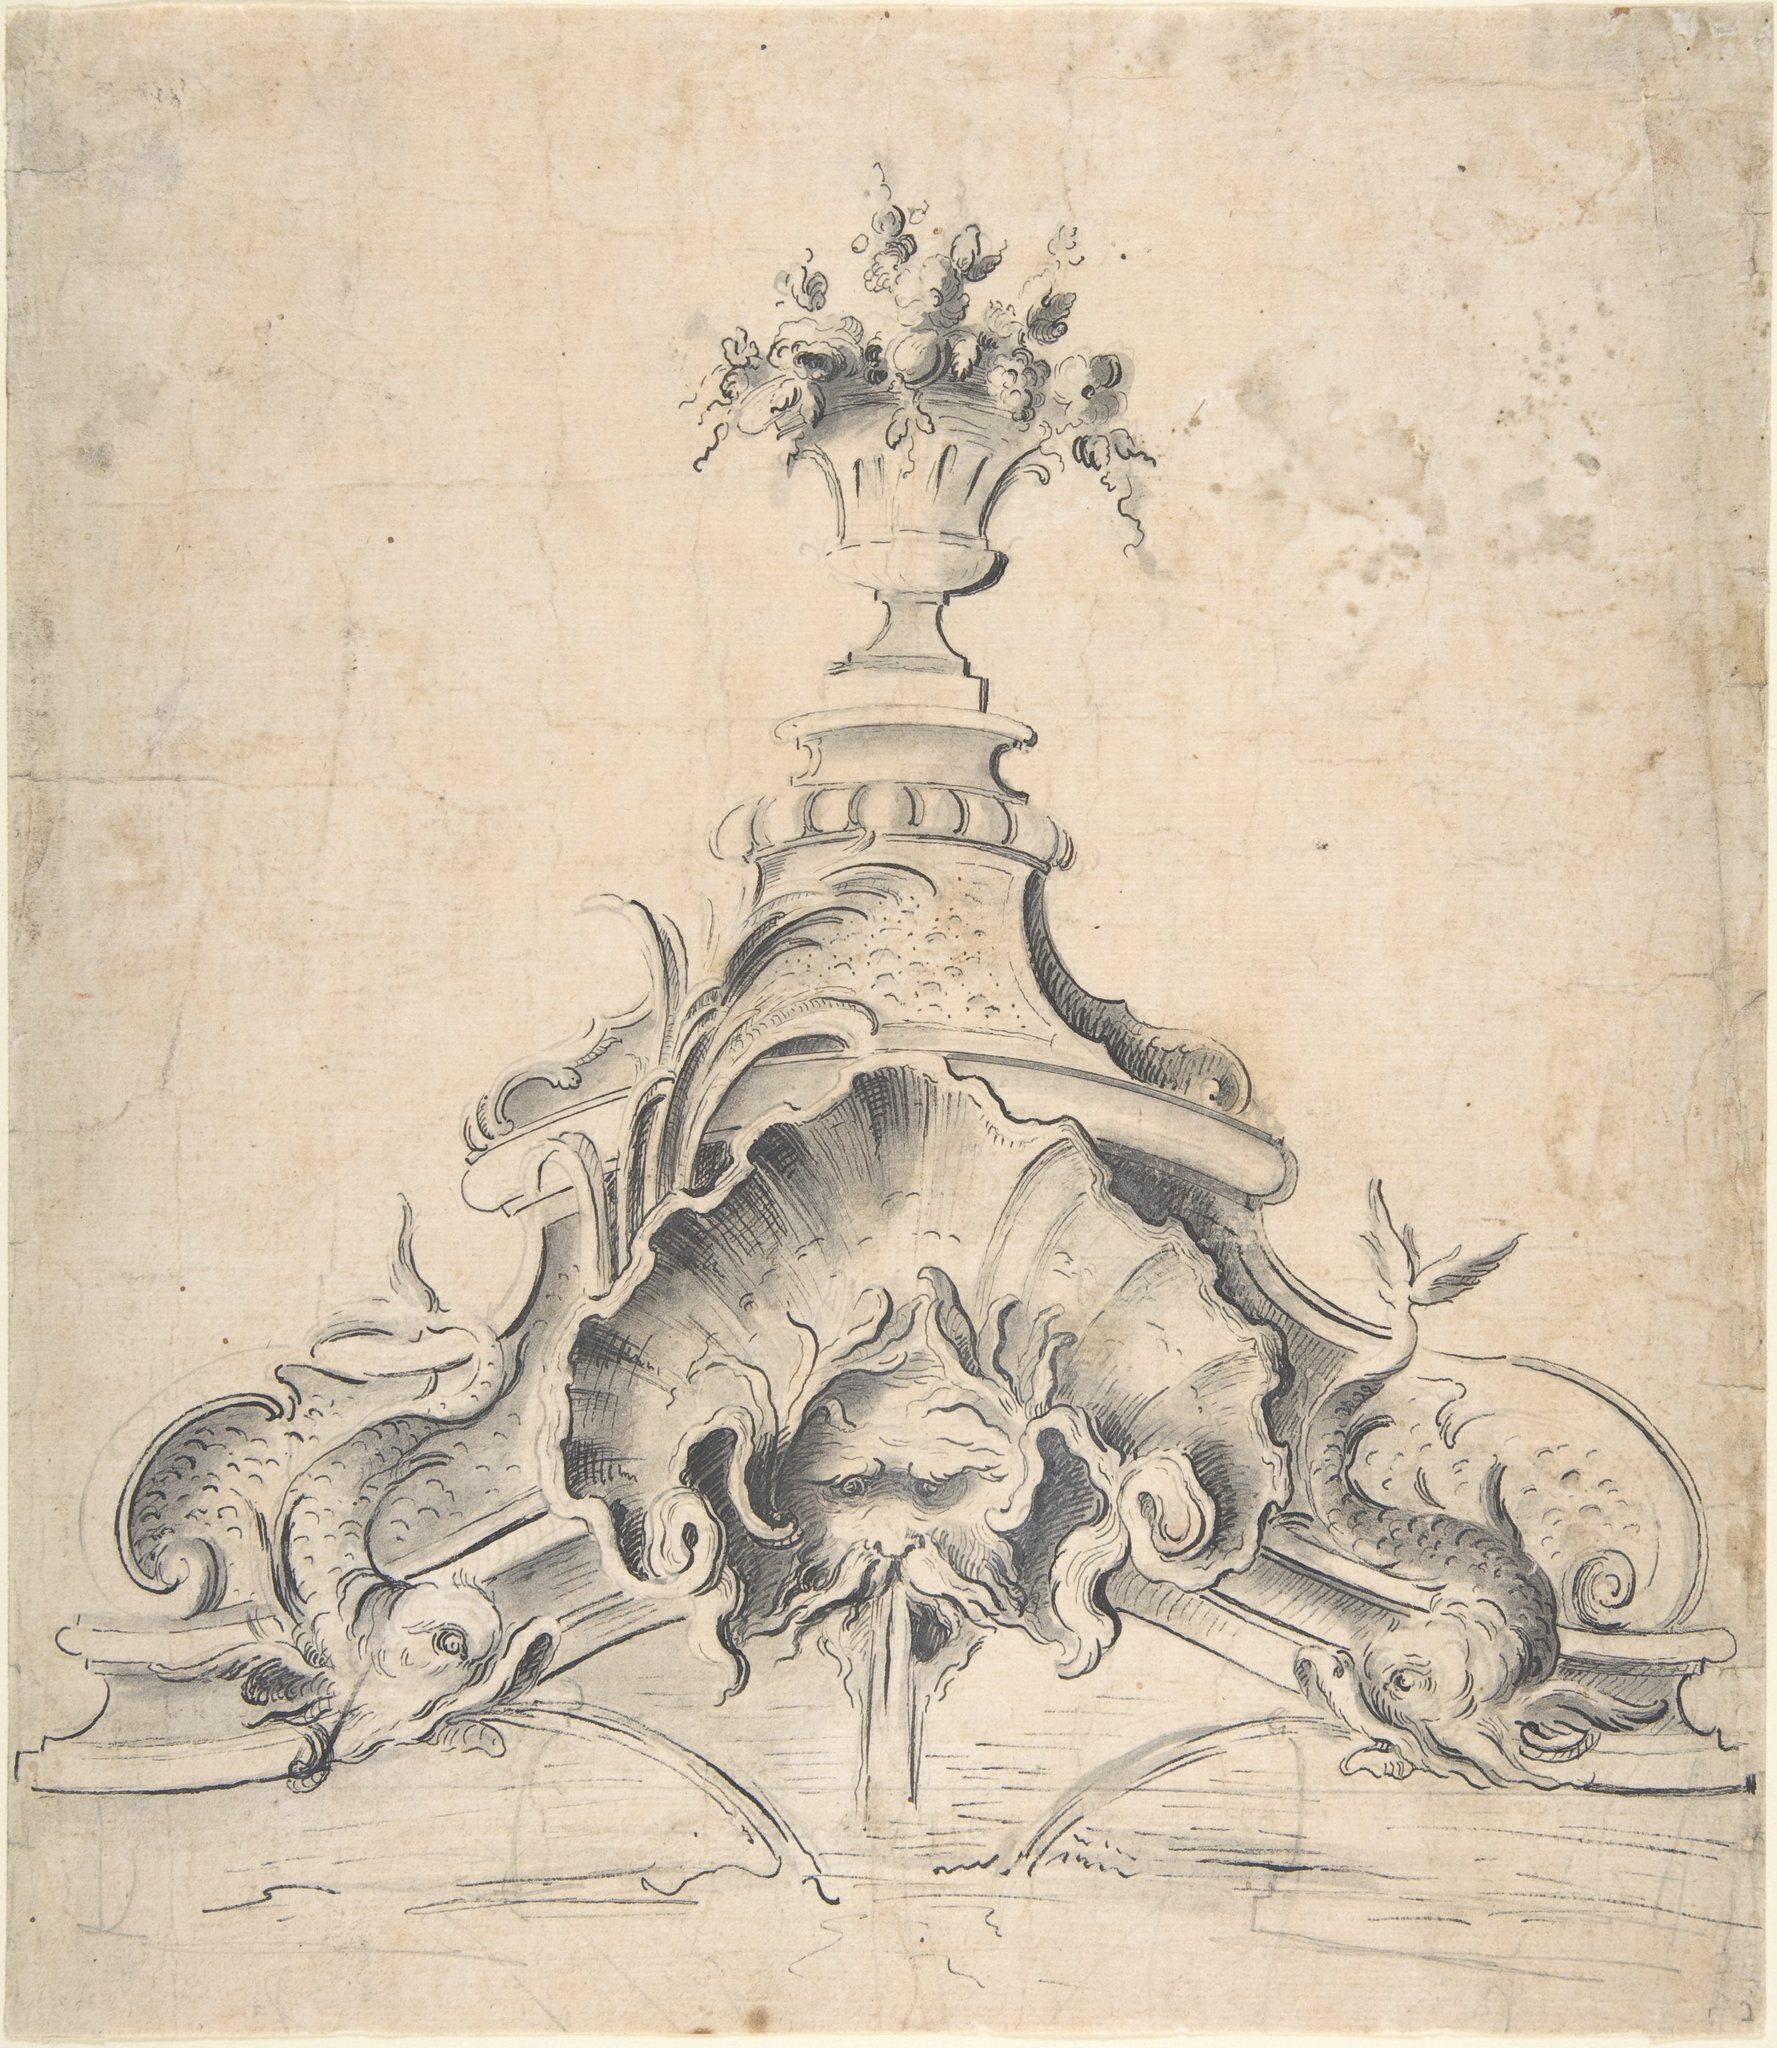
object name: drawing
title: Design for a Fountain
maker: anonymous, french, 18th century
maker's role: artist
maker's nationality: french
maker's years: 1700-1800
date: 1701-1800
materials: graphite, ink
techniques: brush, pen, wash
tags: fountains,fish